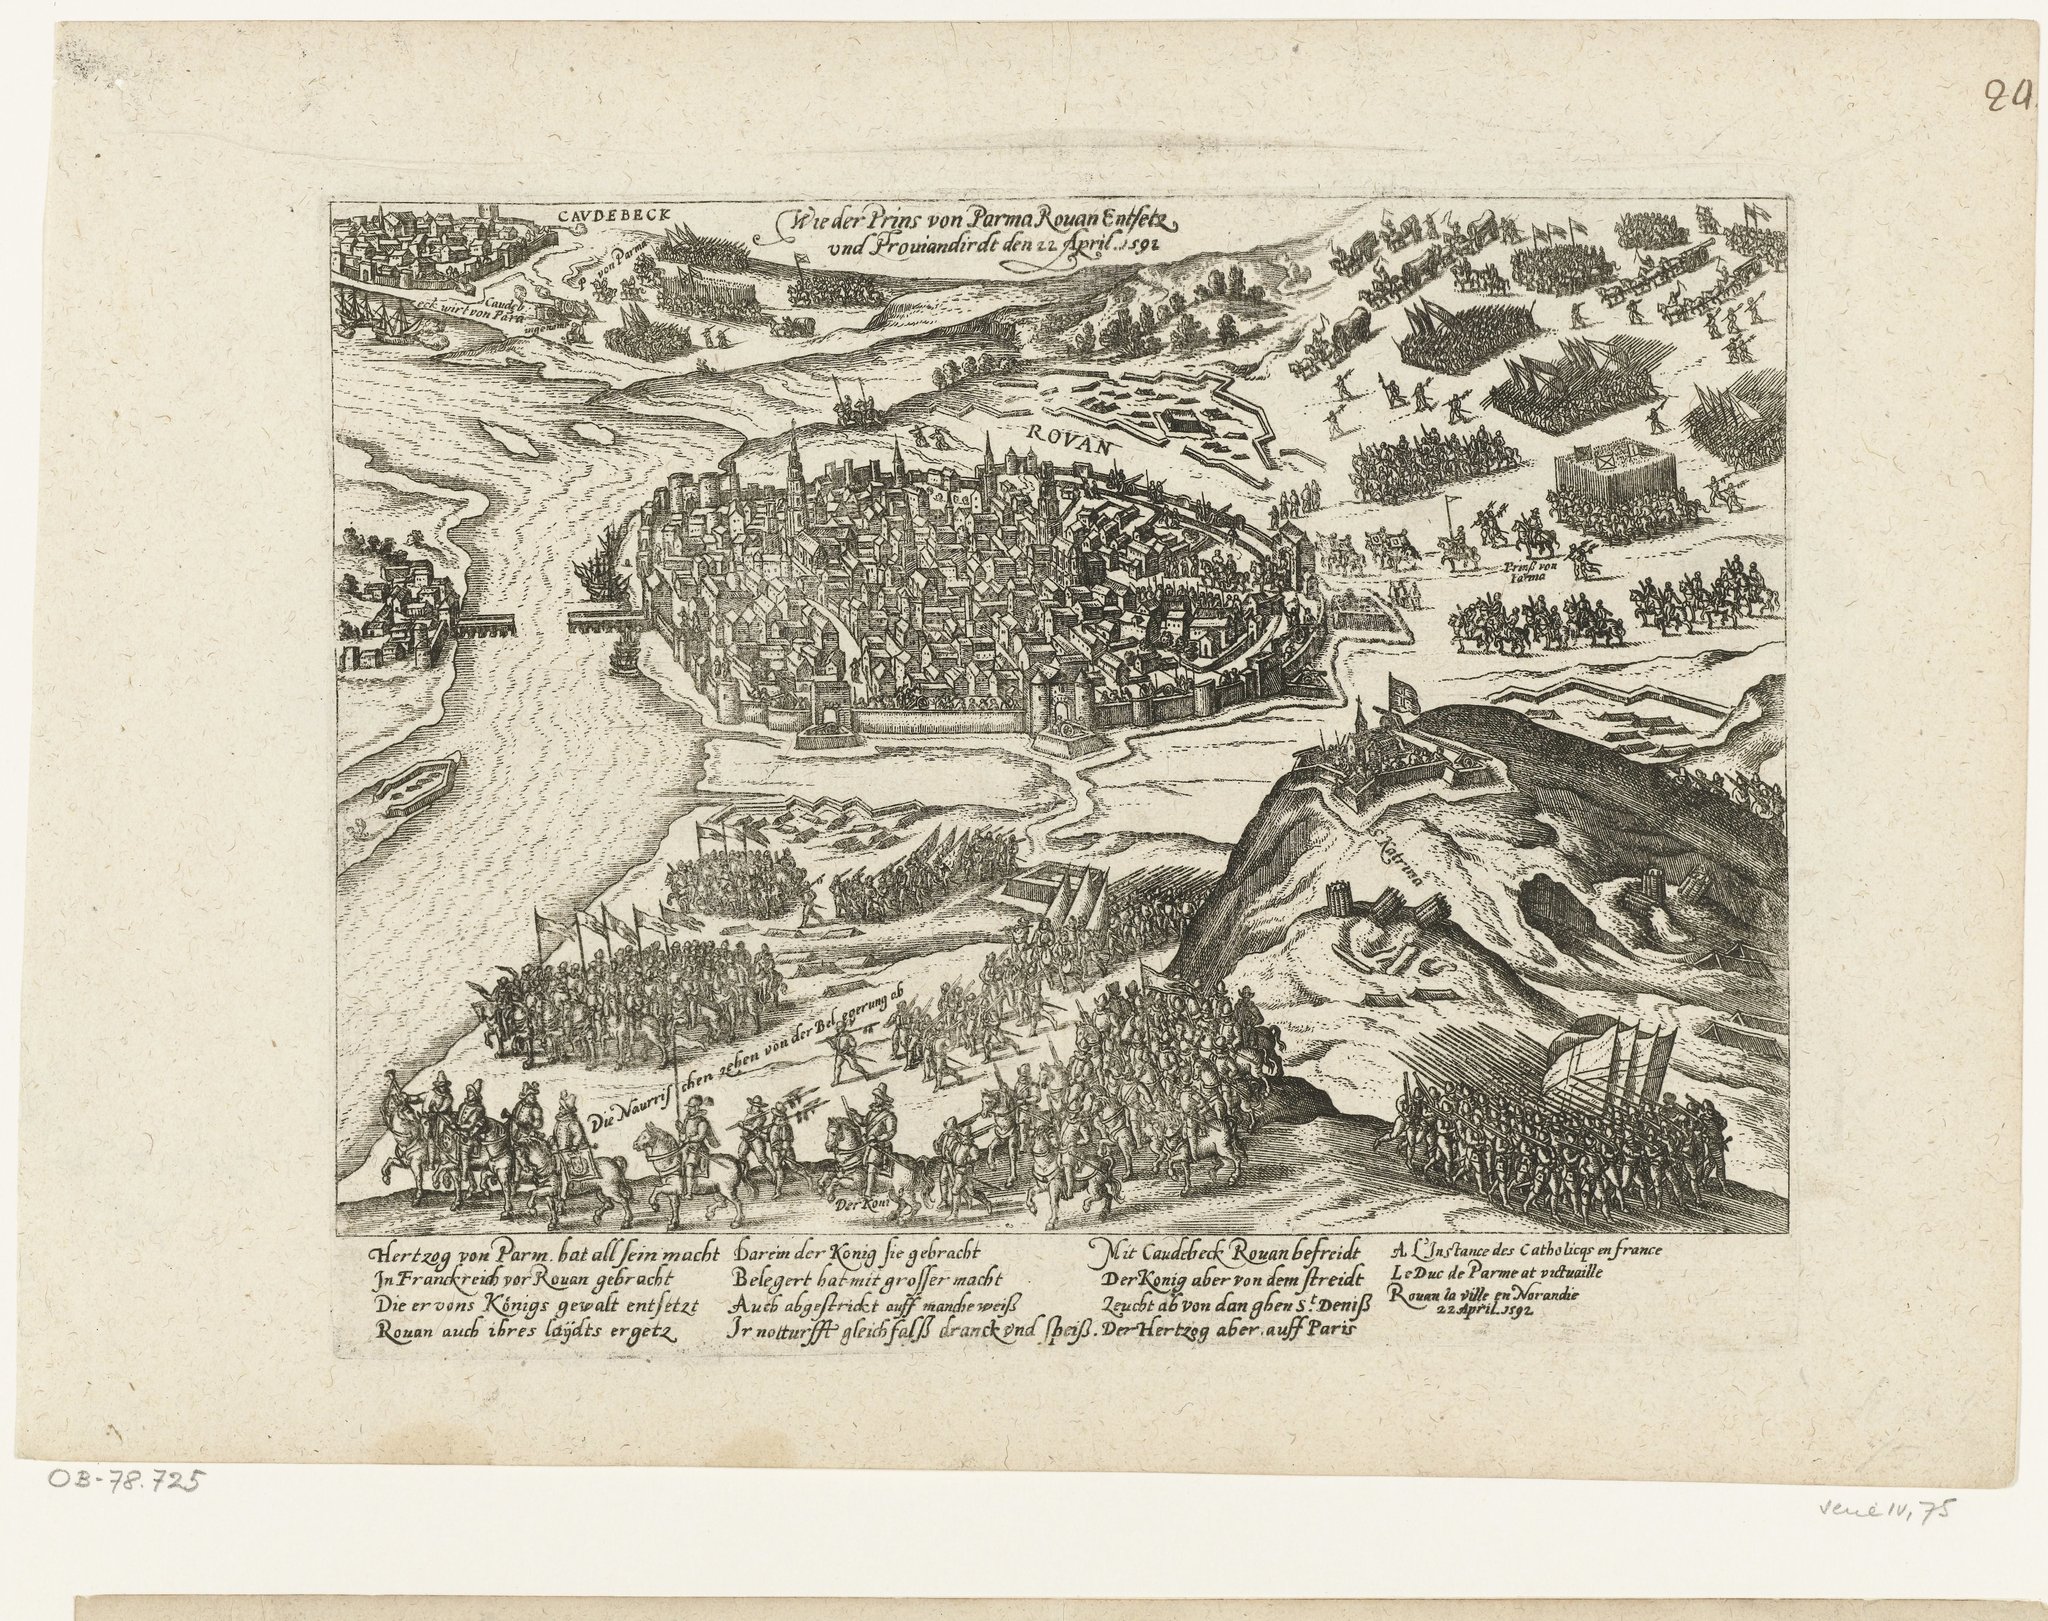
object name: print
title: Wie der Prins von Parma Rouan Entsetz und Proviandirdr den 22 April 1592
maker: frans hogenberg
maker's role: print maker, publisher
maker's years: 1538-1590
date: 1592-1594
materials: paper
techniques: etching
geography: cologne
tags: rome, alessandro farnese (landvoogd van de nederlanden en hertog van parma en piacenza), paris, hendrik iv (koning van frankrijk en navarra), raising the siege with outside assistance, relief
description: Rouen door de hertog van Parma ontzet en van proviand voorzien, 22 april 1592. Rechts boven trekken de troepen van de hertog van Parma op naar de stad, op de voorgrond heffen de troepen van de koning hun beleg op en vertrekken. Met onderschrift van 12 regels in het Duits en 3 regels in het Frans. Ongenummerd. Blad afkomstig uit een album dat uit elkaar is gehaald. Rechtsboven genummerd (in pen): 24(.).